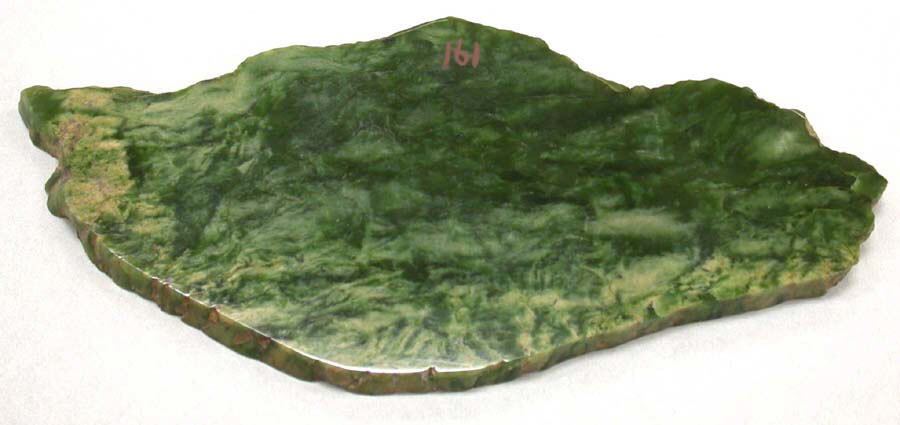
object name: fragment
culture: new zealander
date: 1902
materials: jade